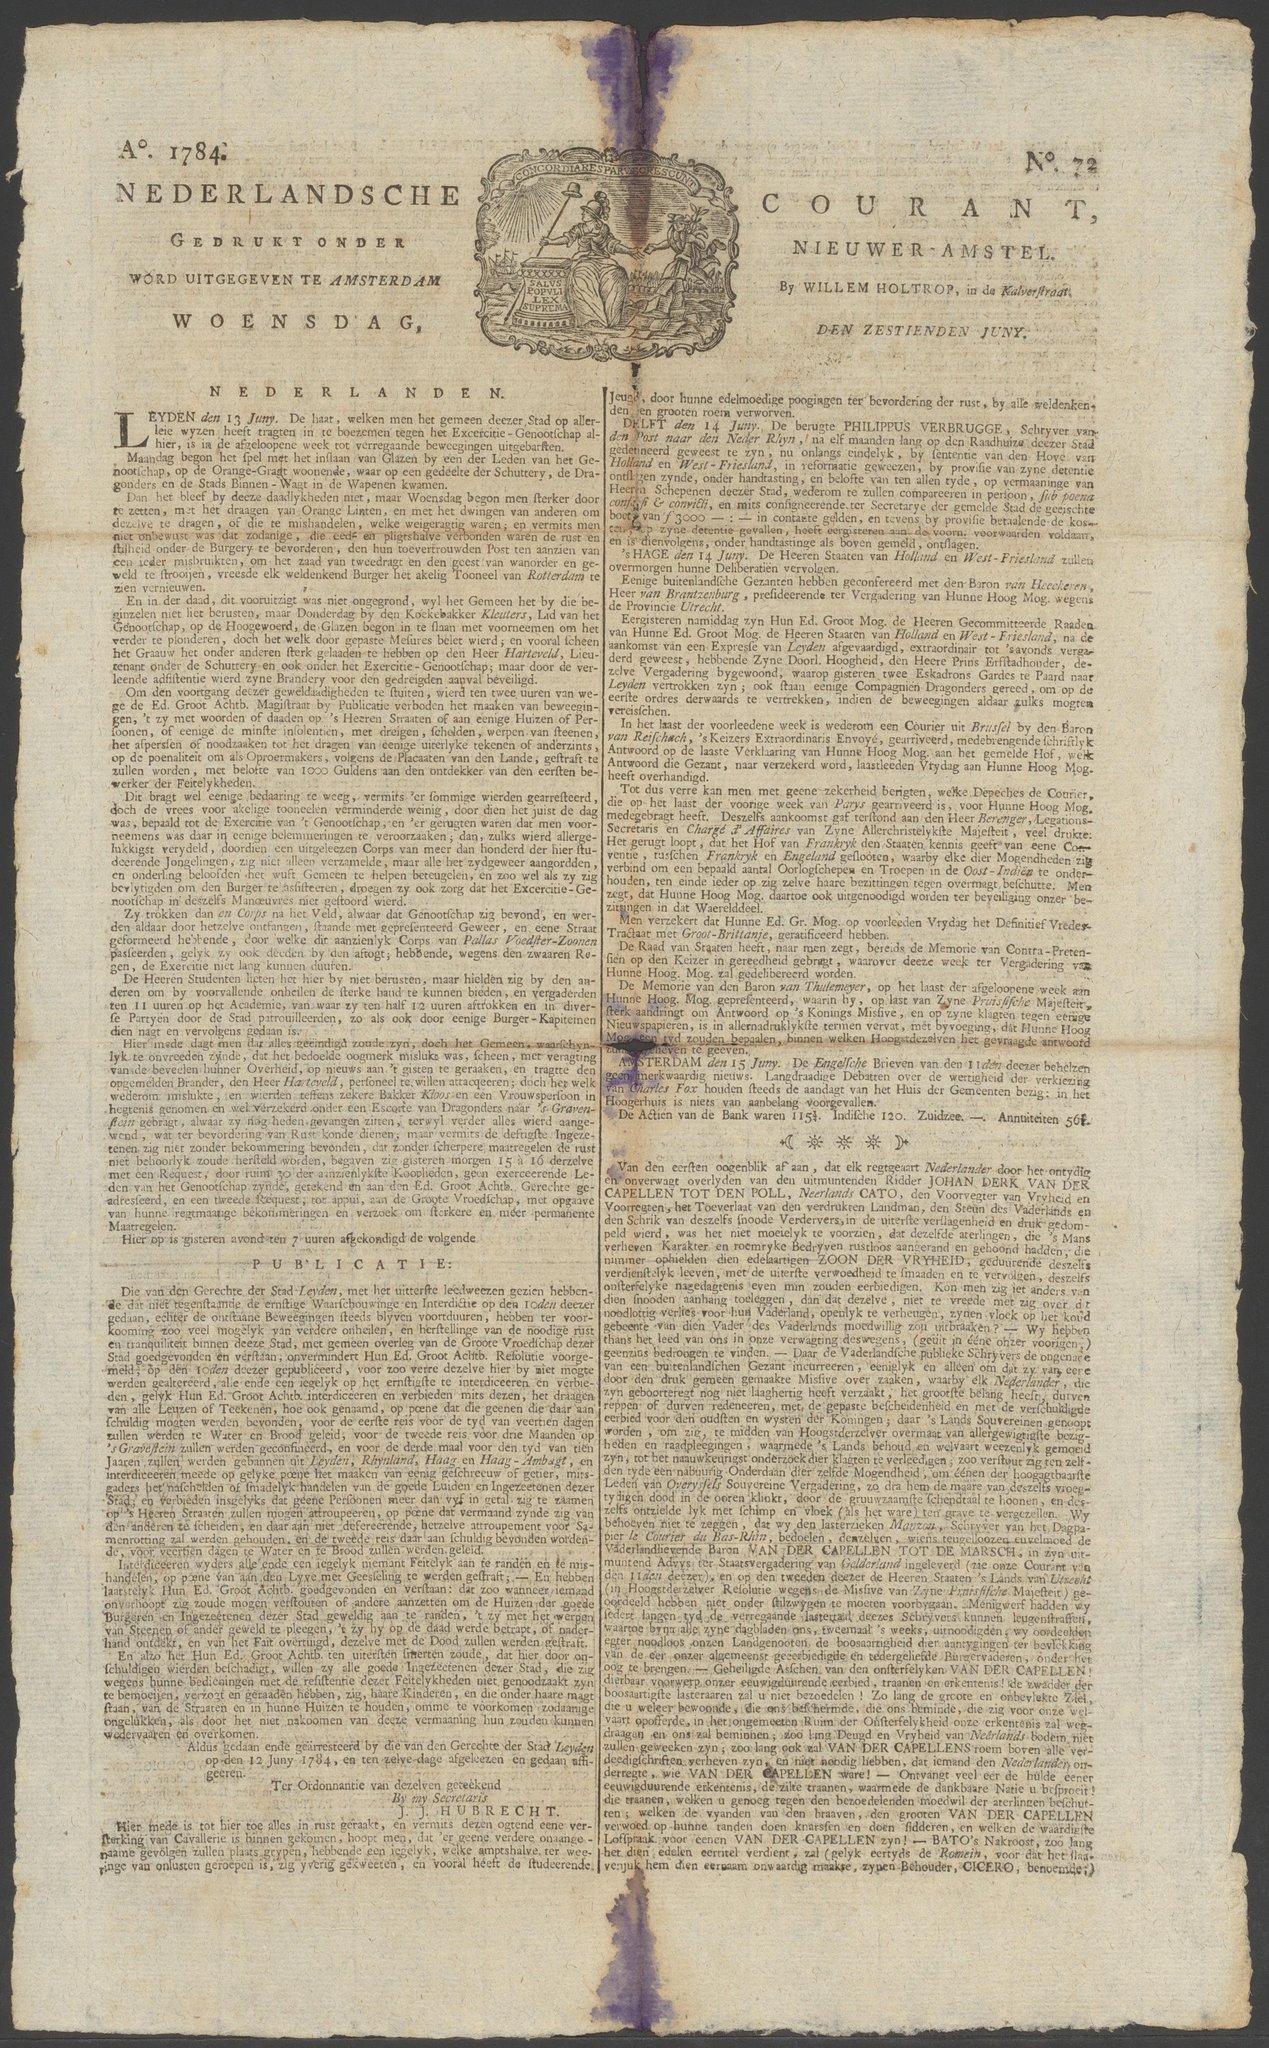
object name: newspaper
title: Nederlandsche Courant, 16 juni 1784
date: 1784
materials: paper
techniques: letterpress printing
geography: nieuwer-amstel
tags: newspaper, news-sheet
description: Exemplaar van de krant 'Nederlandsche Courant' van 16 juni 1784. Enkelbladig, beide zijden bedrukt. Bovenaan een vignet met de Vrijheid en Mercurius. Onderwerpsrubrieken binnen de Atlas Zeden en Gewoonten: Regeering, Officieele Nieuwsbladen.